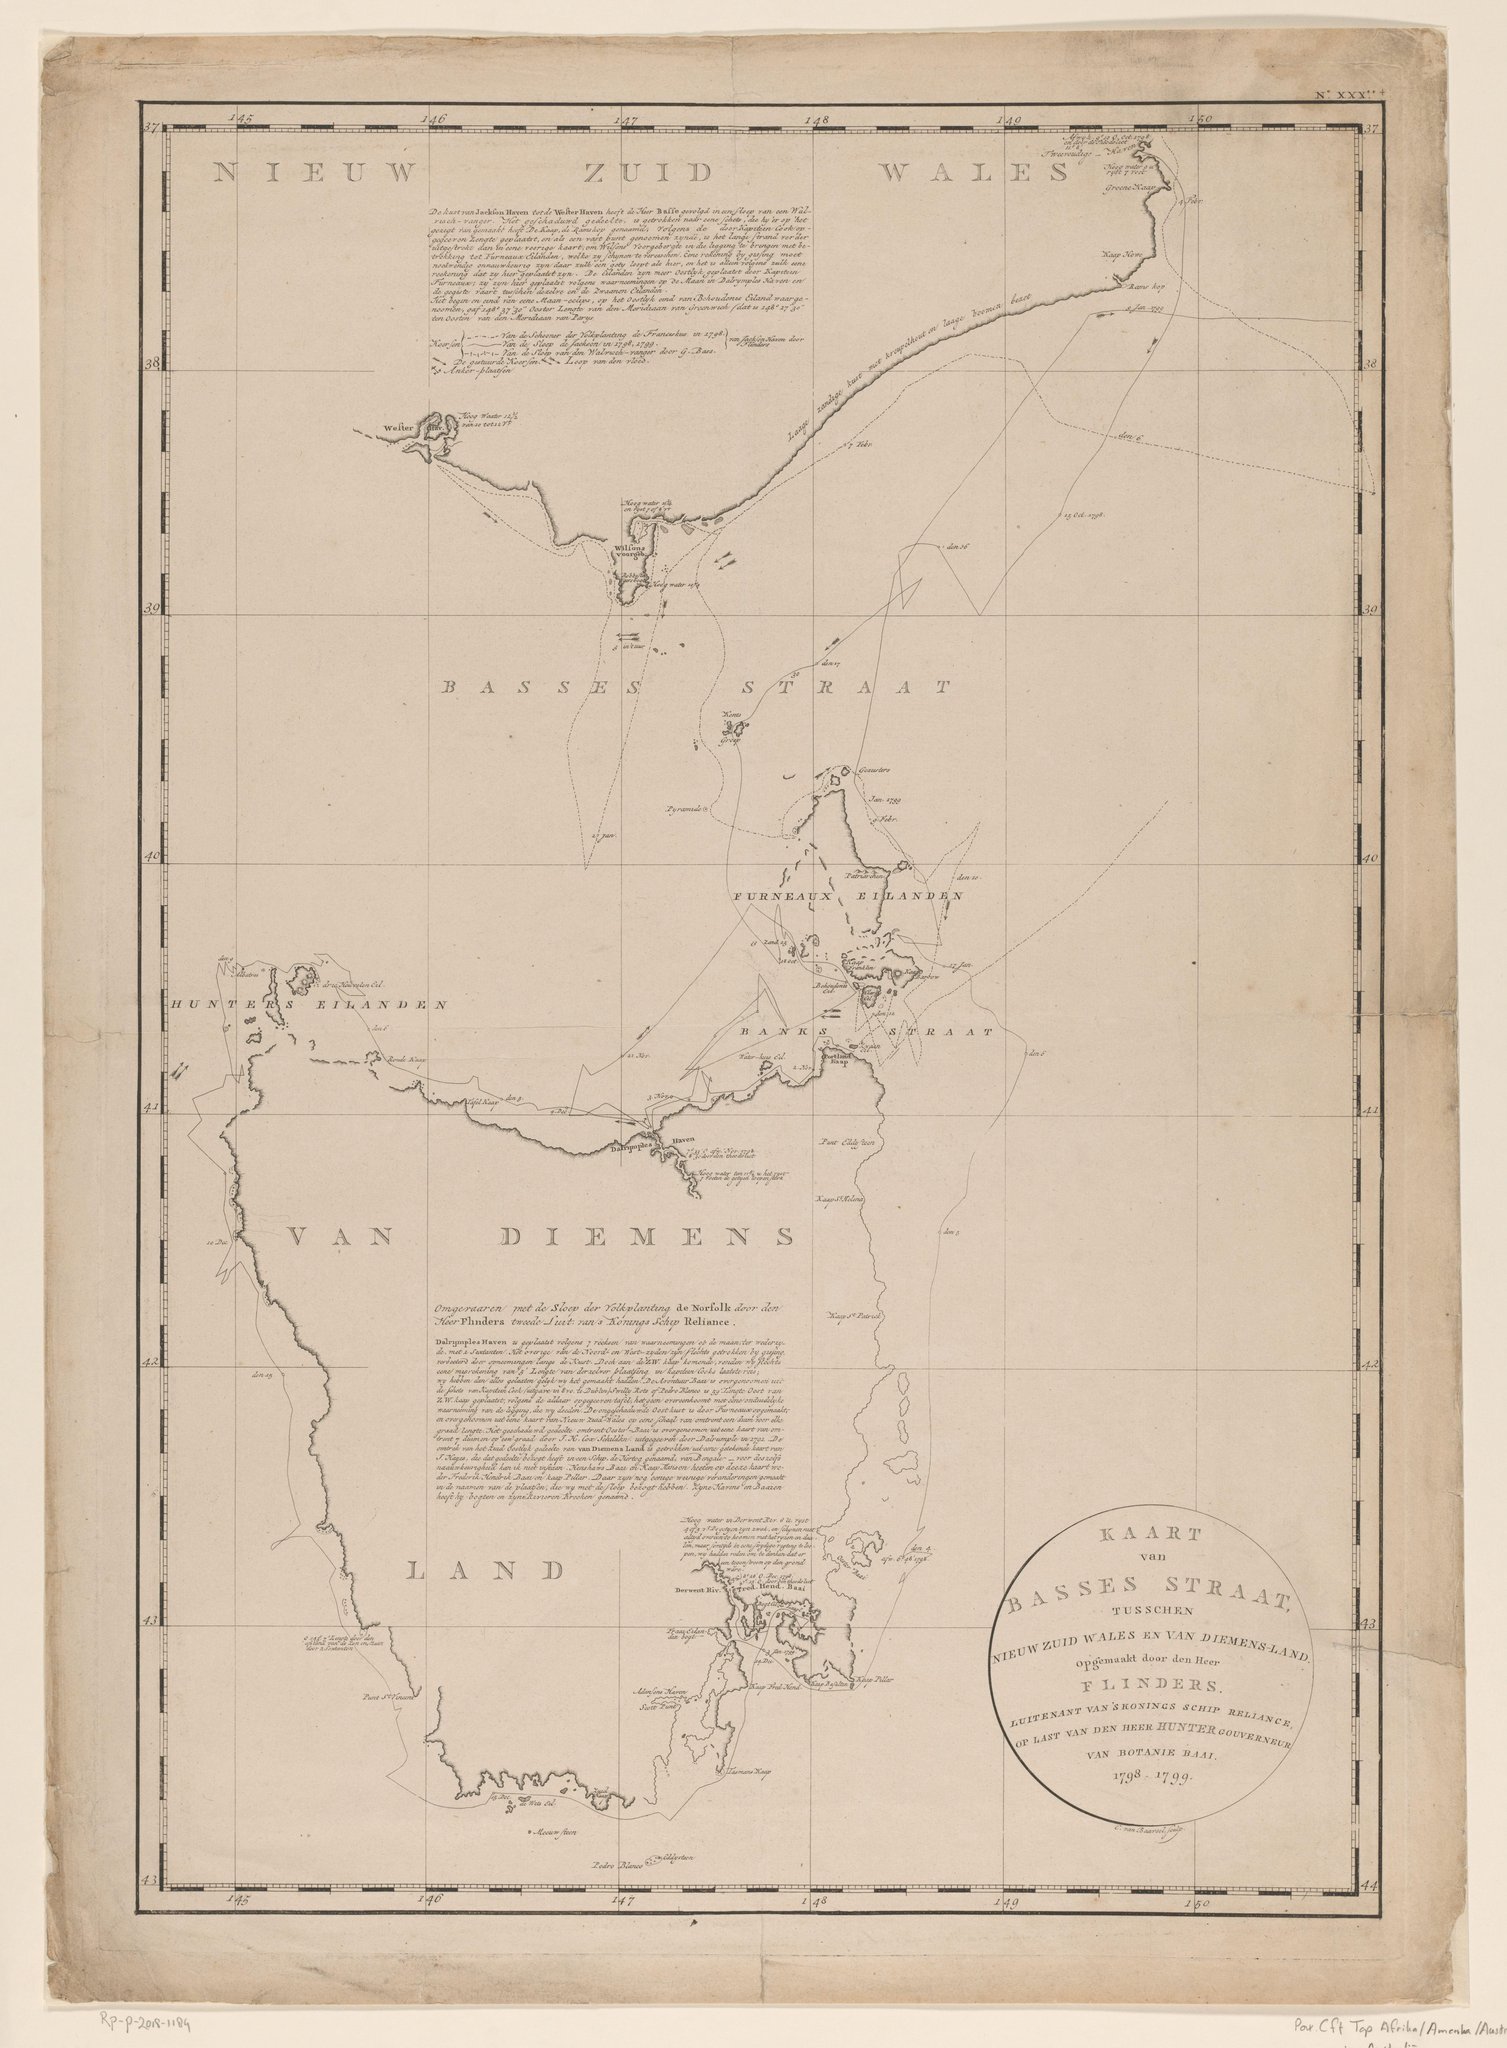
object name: print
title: Kaart van Basses Straat tusschen Nieuw Zuid Wales en Van Diemens-Land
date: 1795-1809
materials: paper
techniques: engraving, etching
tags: marine charts, maps of separate countries or regions, exploration, expedition, voyage of discovery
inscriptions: collector's mark: Lugt 2228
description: Prent ook gebruikt in: Cook, James. Reize rondom de waereld. 13 dln. Amsterdam: Isaak vn Cleef, Leiden: Jan en Abraham Honkoop, Den Haag: Johannes Allart, 1795-1809.